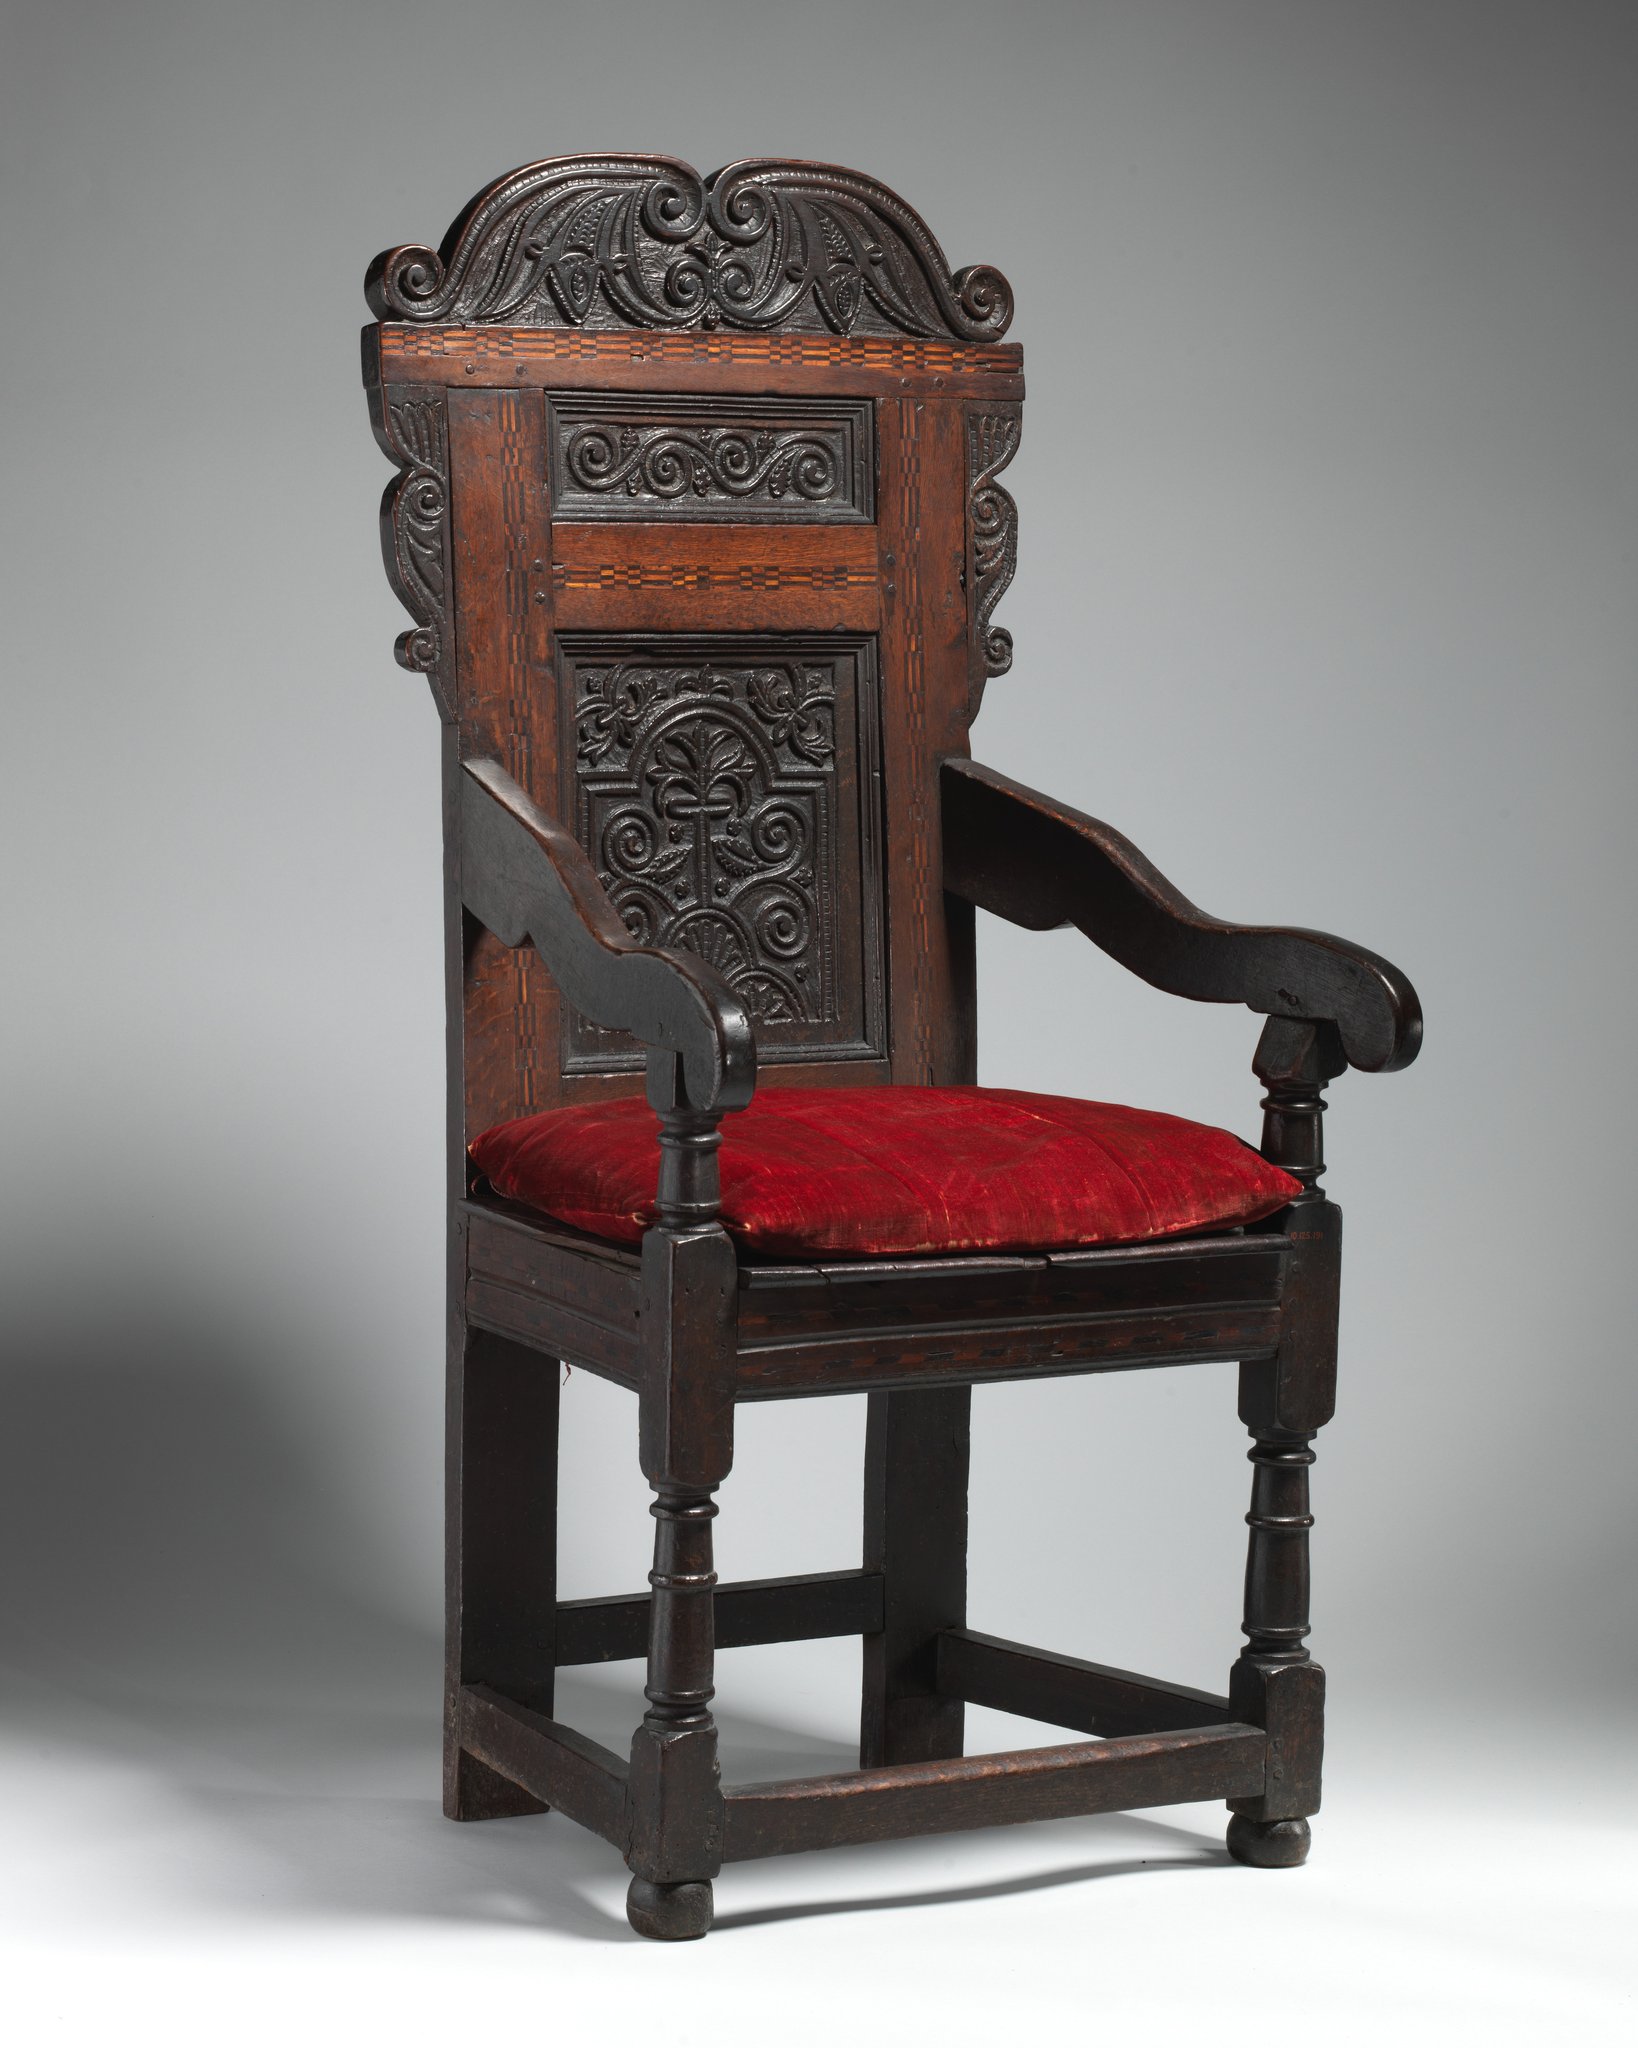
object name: armchair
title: Wainscot armchair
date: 1600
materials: wood